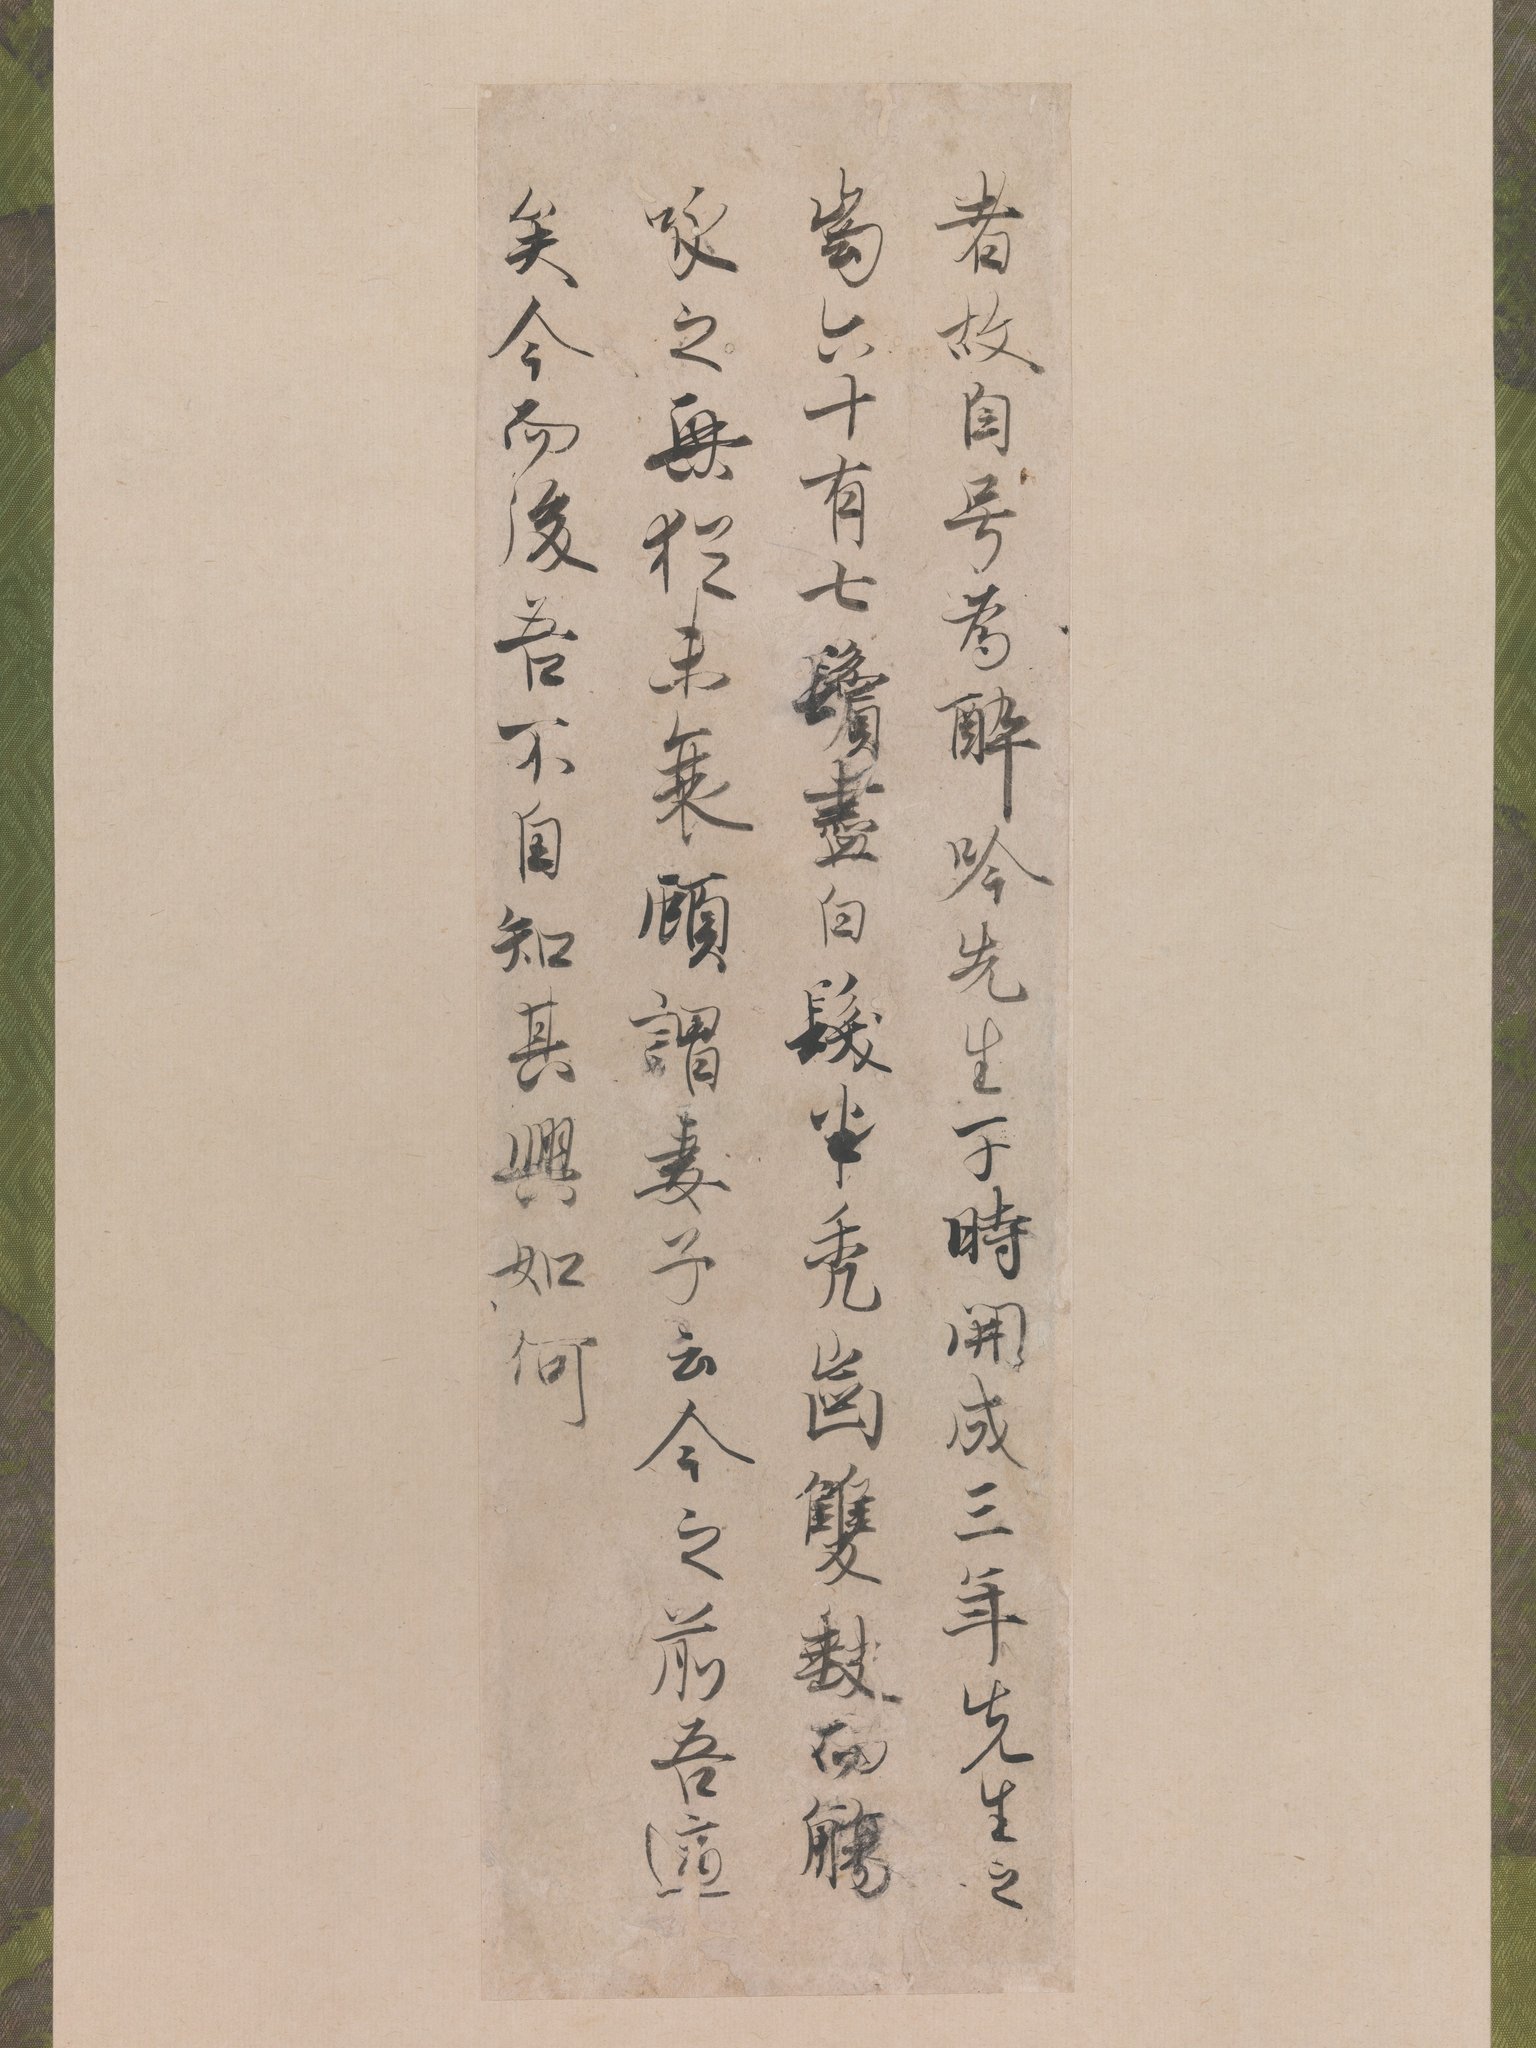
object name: hanging scroll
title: Excerpt from Bai Juyi's "Autobiography of a Master of Drunken Poetry Recitation"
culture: japanese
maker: fujiwara no yukinari (kōzei)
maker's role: artist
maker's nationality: japanese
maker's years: 972-1027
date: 1001-1033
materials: ink, paper